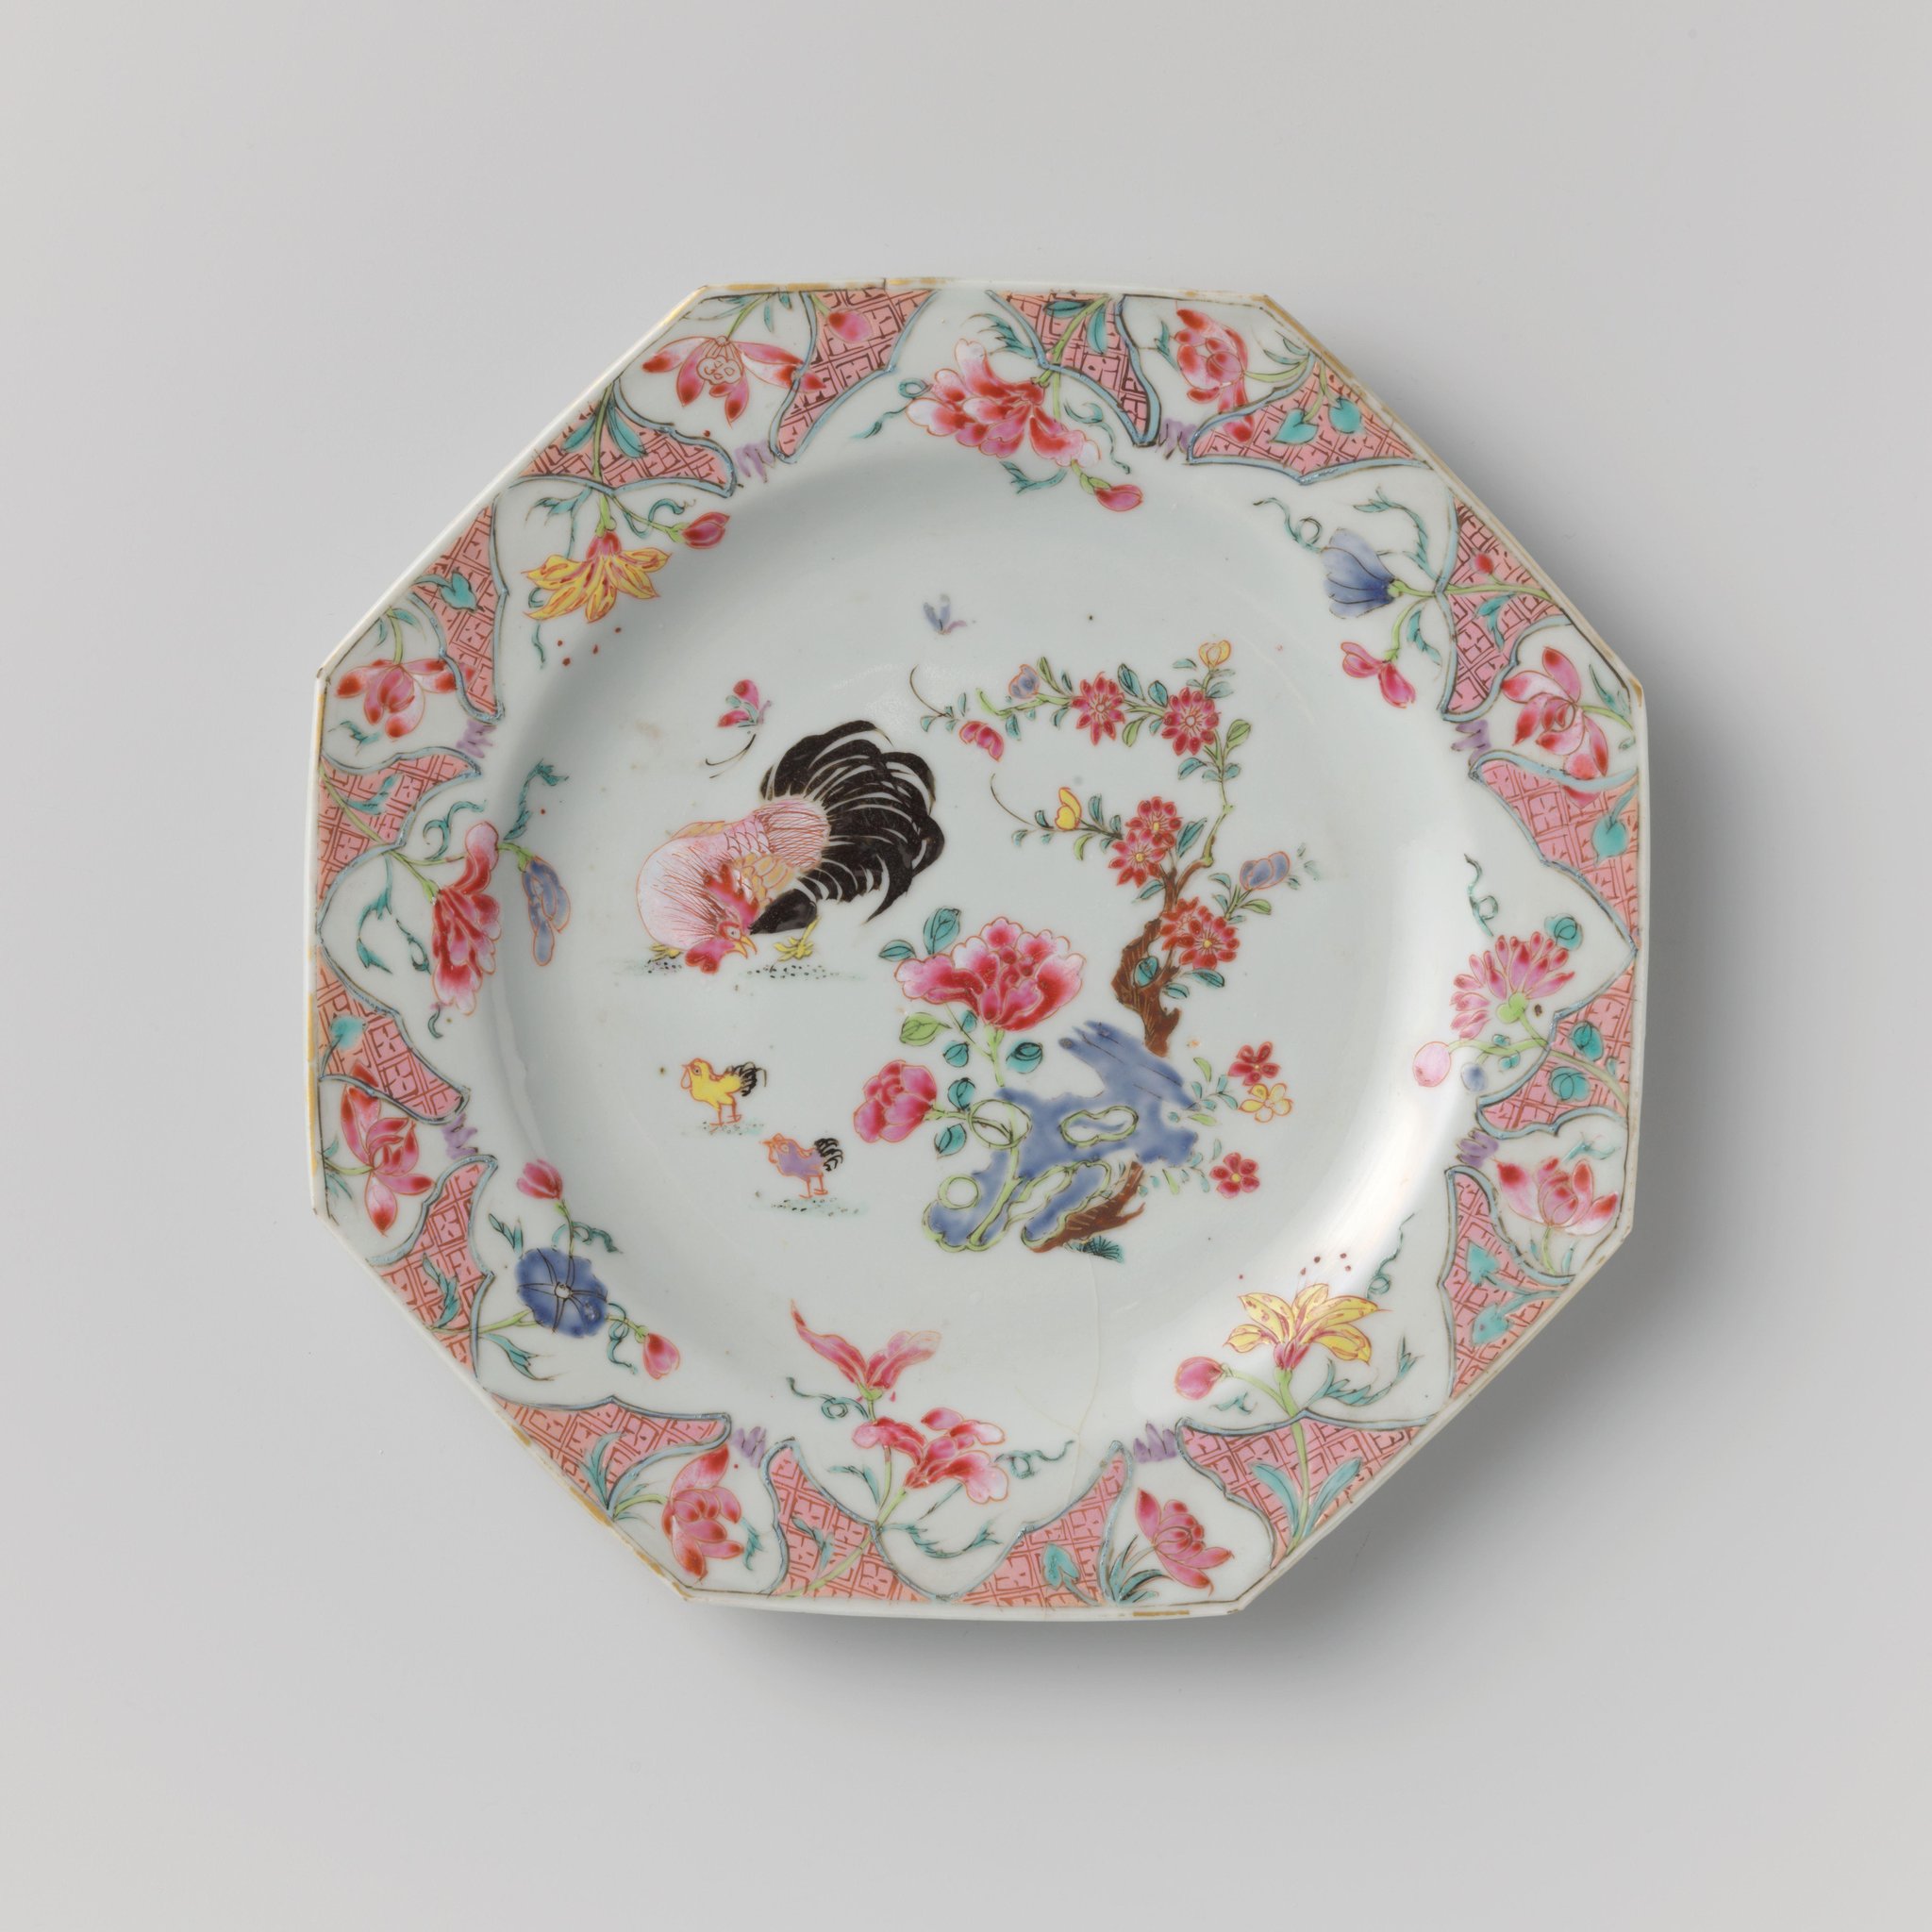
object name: plate dish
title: Octagonal plate with a cock and two little chickens near a rock with flowering plants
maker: Anonymous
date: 1725-1749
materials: glaze, gold, paint, porcelain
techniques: firing, forming, gilding, turning, vitrification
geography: china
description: Achthoekig bord van porselein, beschilderd op het glazuur in blauw, rood, roze, groen, geel, turquoise, paars, zwart en goud. Op het plat een haan en twee kleine kippen bij een rots met bloeiende planten, in de lucht enkele insecten; de rand met een ingewikkelde band met servetwerk en verschillende bloeiende planten. Famille rose.